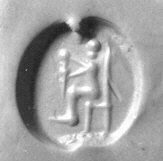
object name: stamp seal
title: Stamp seal (scaraboid) with deity (?)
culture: assyro-babylonian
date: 700-501 BCE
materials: stone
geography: mesopotamia or syria